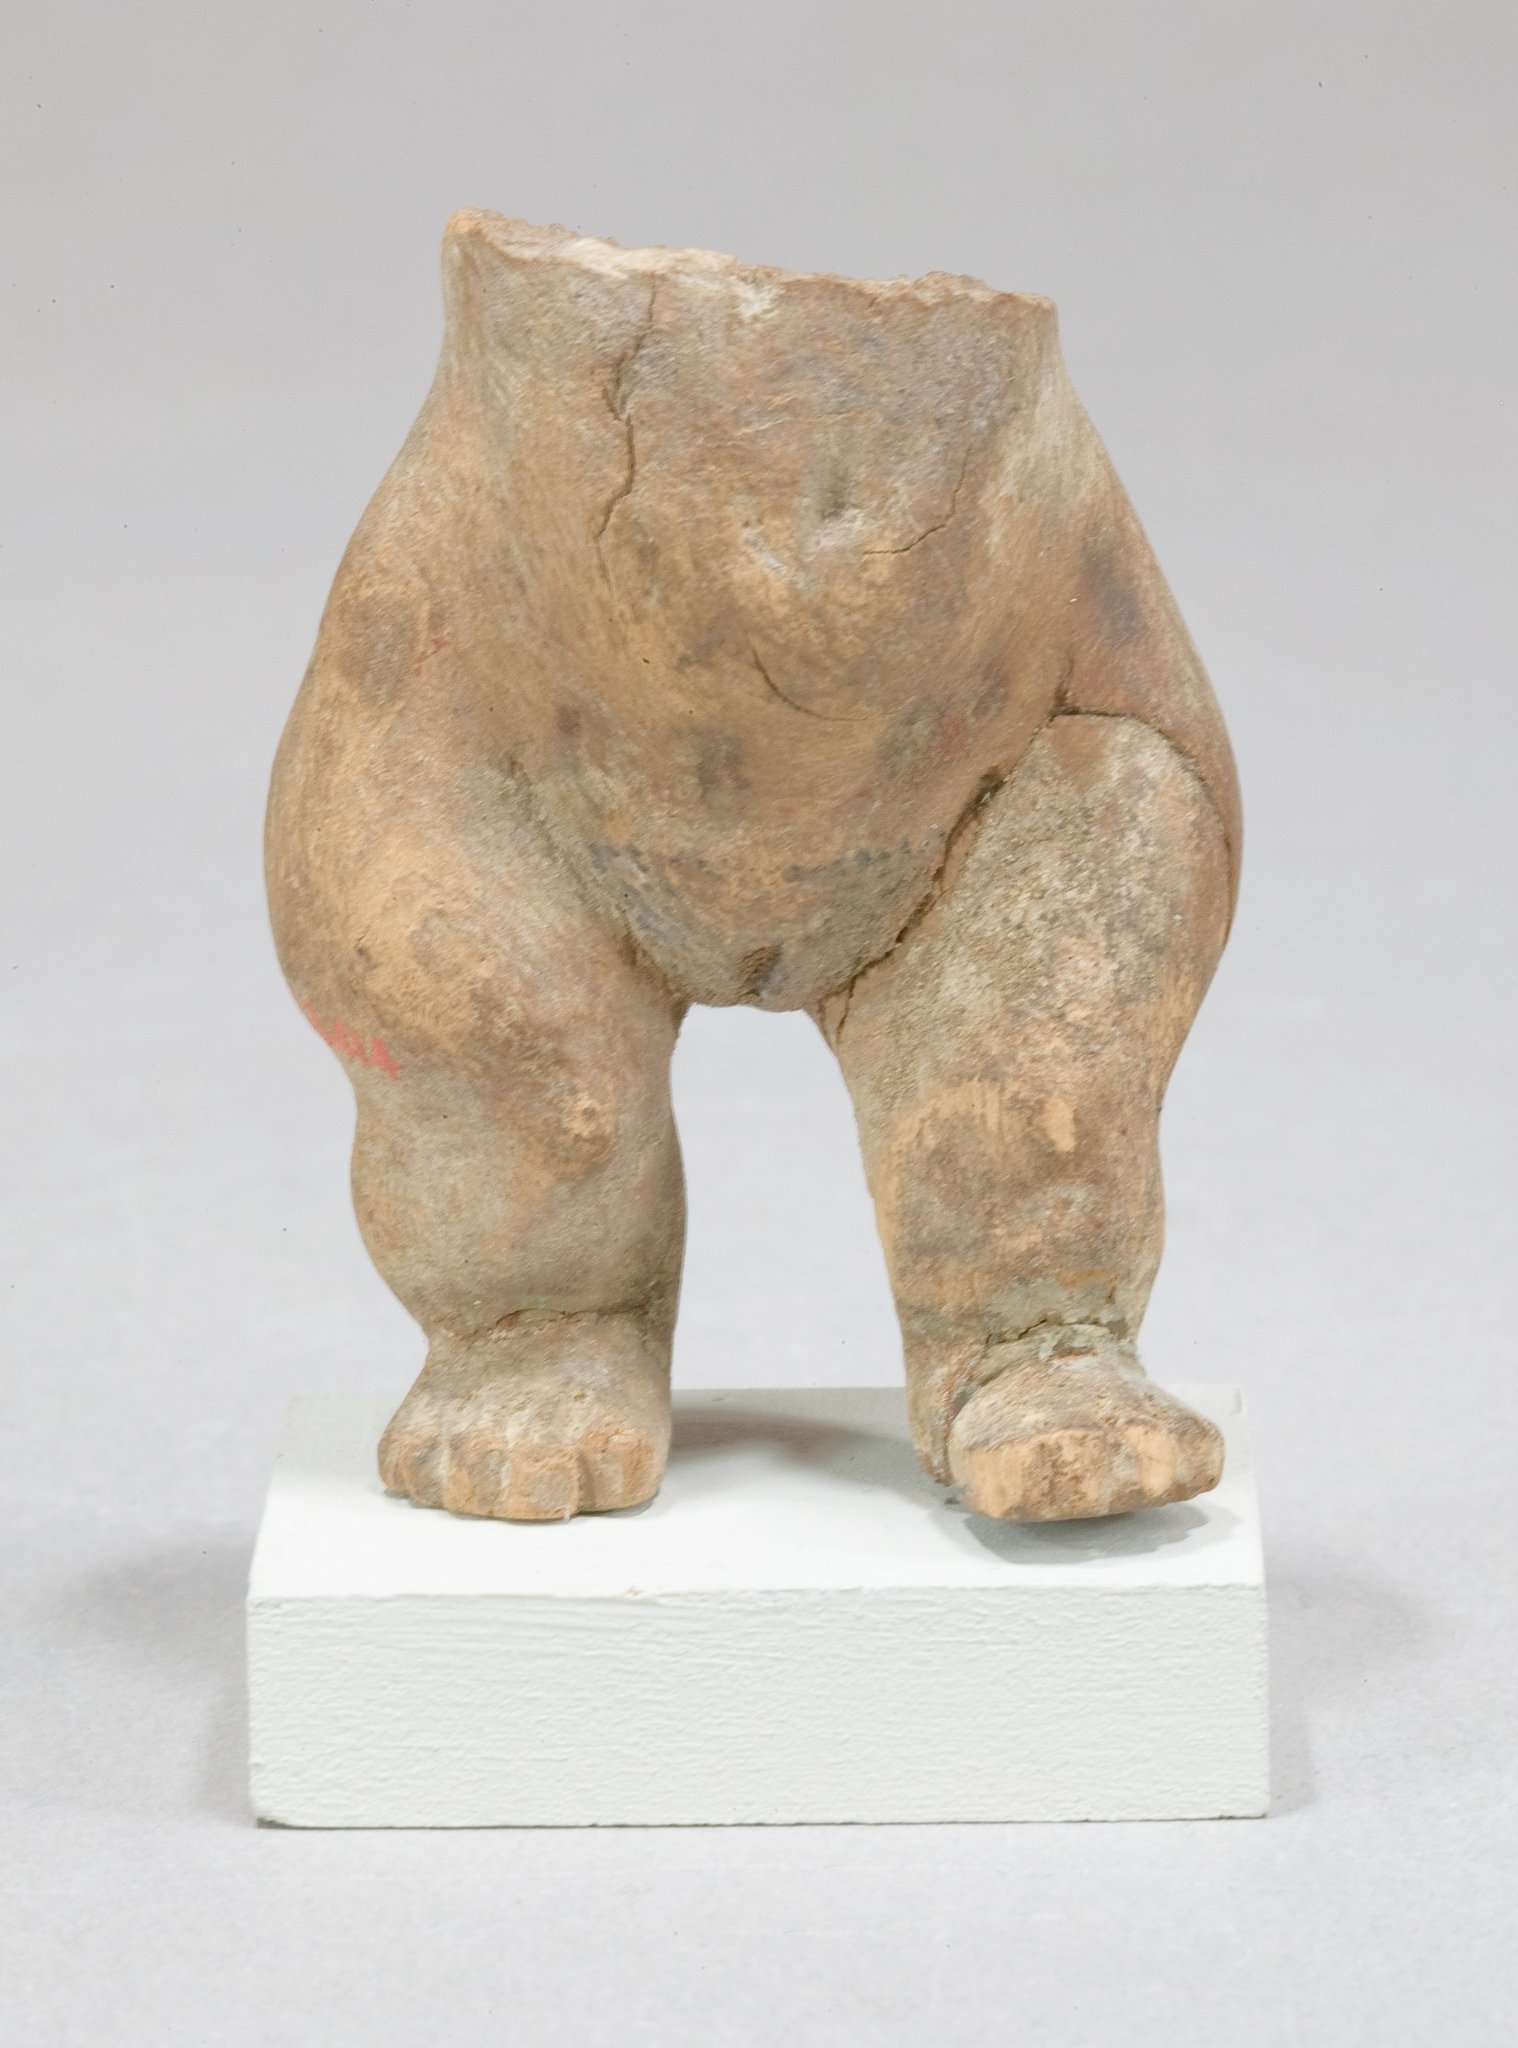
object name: statuette, dwarf, lower half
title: Female dwarf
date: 1700-1550 BCE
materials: paint, wood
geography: egypt